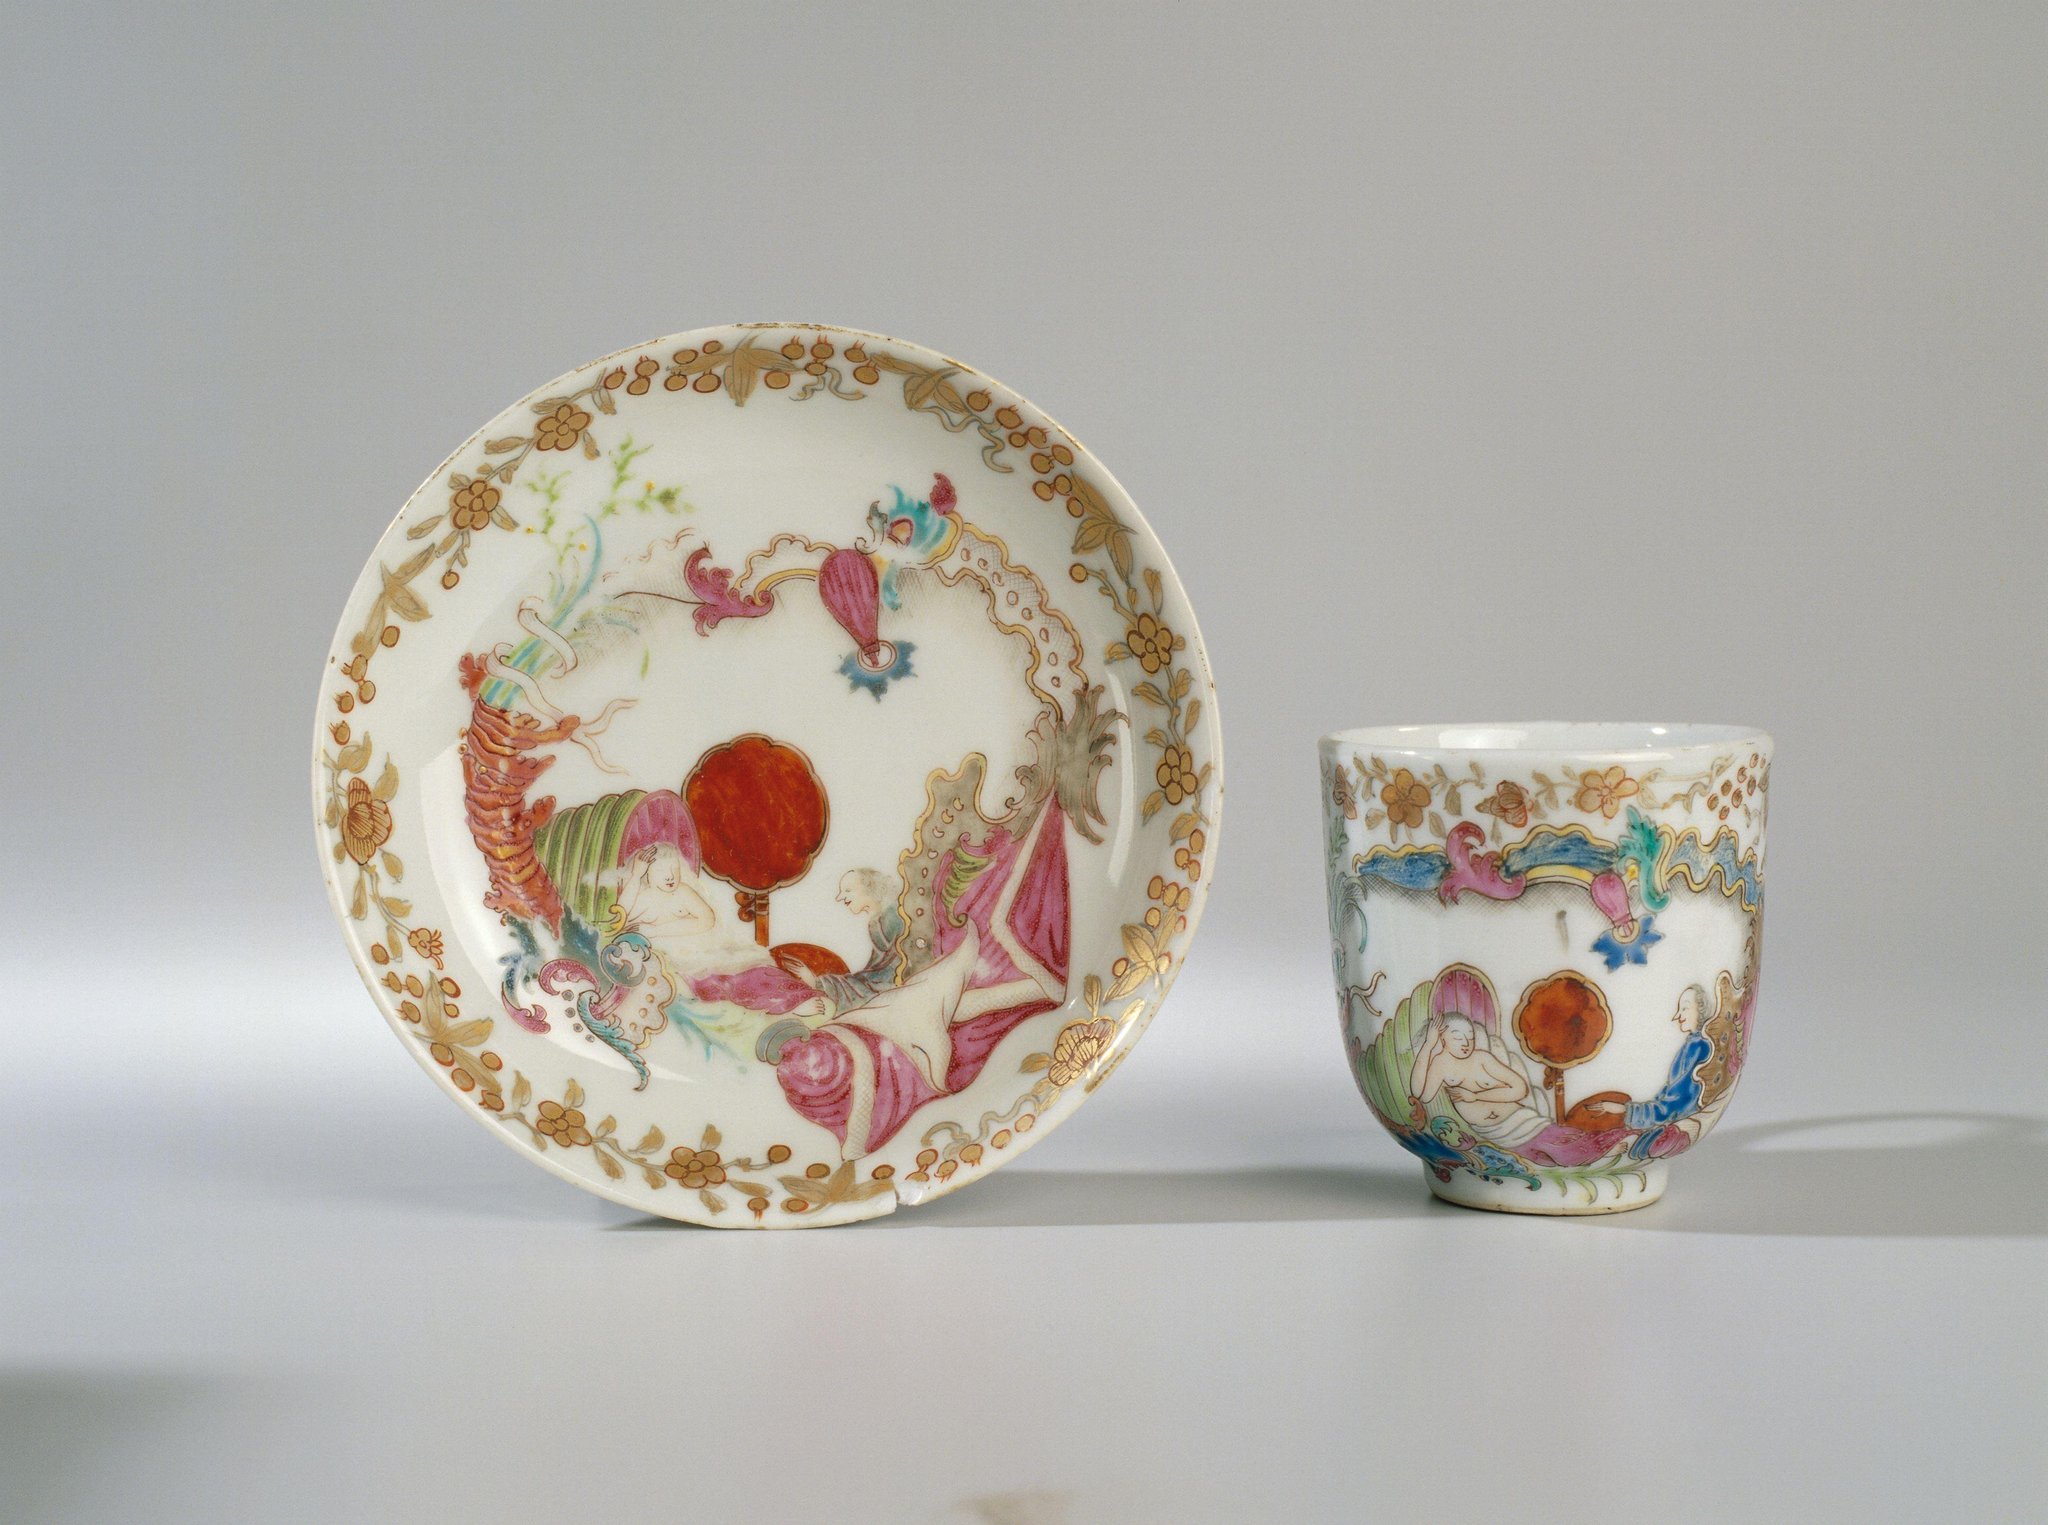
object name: cup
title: Bell-shaped cup with an erotic scene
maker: Anonymous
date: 1745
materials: glaze, gold, paint, porcelain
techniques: firing, gilding, turning, vitrification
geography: china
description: Platte schotel op een voetring, gedecoreerd in emailkleuren. Zowel op de schotel als op de kop een voorstelling van een man en een half ontklede vrouw. Op het porselein is de letter A aangebracht. De randen van de kop en schotel zijn versierd met slingerende bloemtakken. Porselein met erotische scènes zoals deze vormen een aparte subgroep binnen het Deze kunnen variëren van zeer pornografisch tot milde erotische weergaven van klassieke mythologische liefdesverhalen. Mogelijk wijst de letter A erop dat dit porselein bestemd was voor een bepaalde persoon.